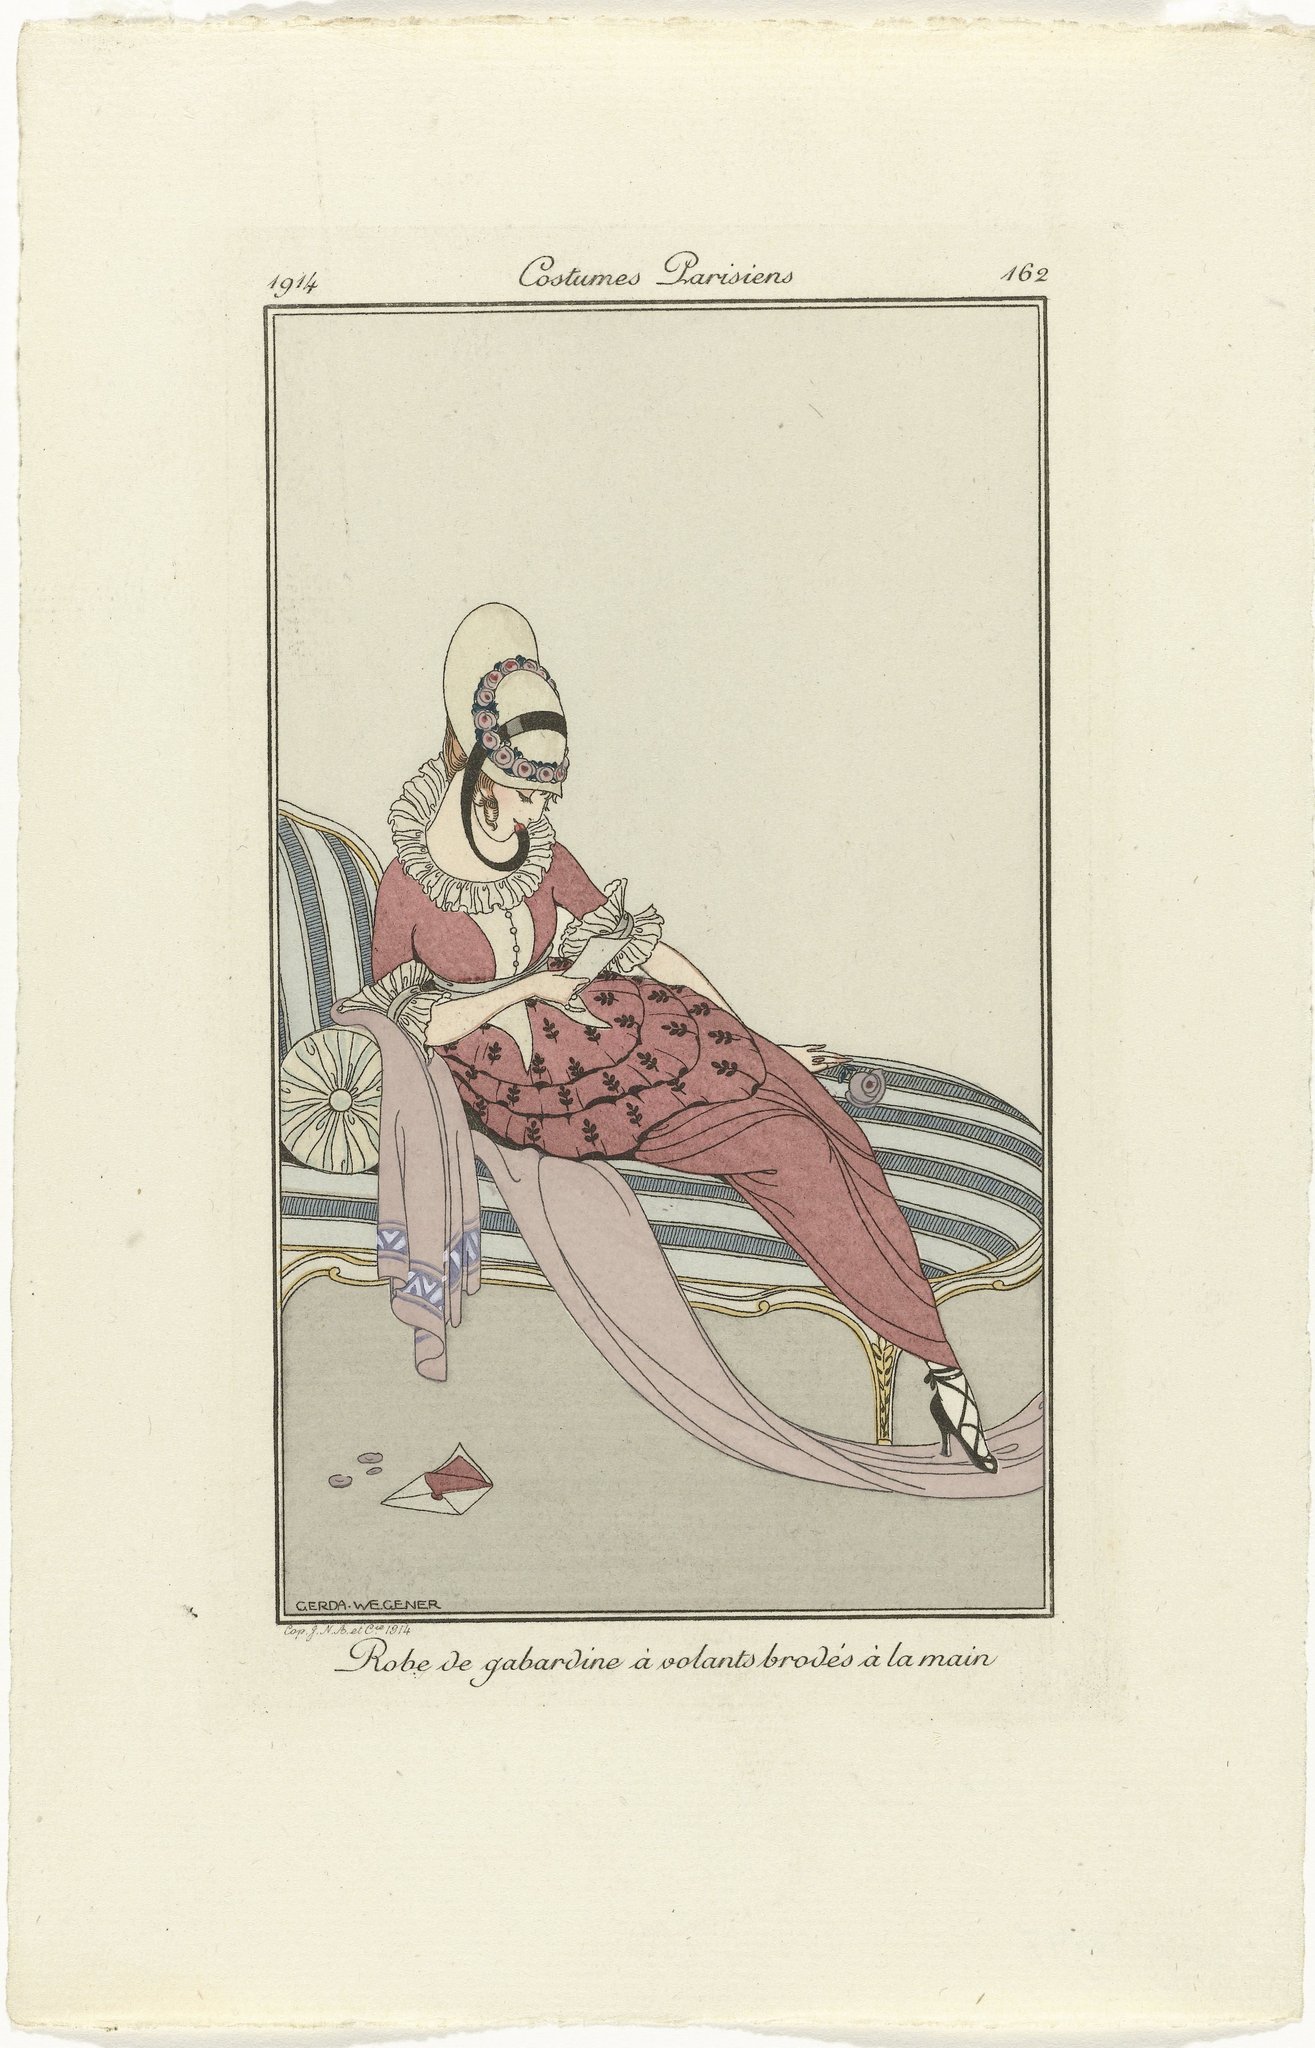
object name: fashion print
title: Journal des Dames et des Modes, Costumes Parisiens, 1914, No. 162 : Robe de gabardin (...)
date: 1914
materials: paper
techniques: engraving, hand coloring, pochoir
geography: paris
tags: flowers, seating furniture, clothing for the upper part of the body (shawl) (+ women's clothes), reading, embroidery (ornamentation) (+ women's clothes), head-gear (+ women's clothes), fashion plates, dress, gown (+ women's clothes), letter, envelope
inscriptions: title: ‘Costumes Parisiens’, caption: ‘Robe de gabardine a volants brodés a la main.’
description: Vrouw, zittend op een chaise longue, gekleed in een japon van gabardine met geplooide stroken die met de hand zijn geborduurd. Prent uit het modetijdschrift Journal des Dames et des Modes (1912-1914).